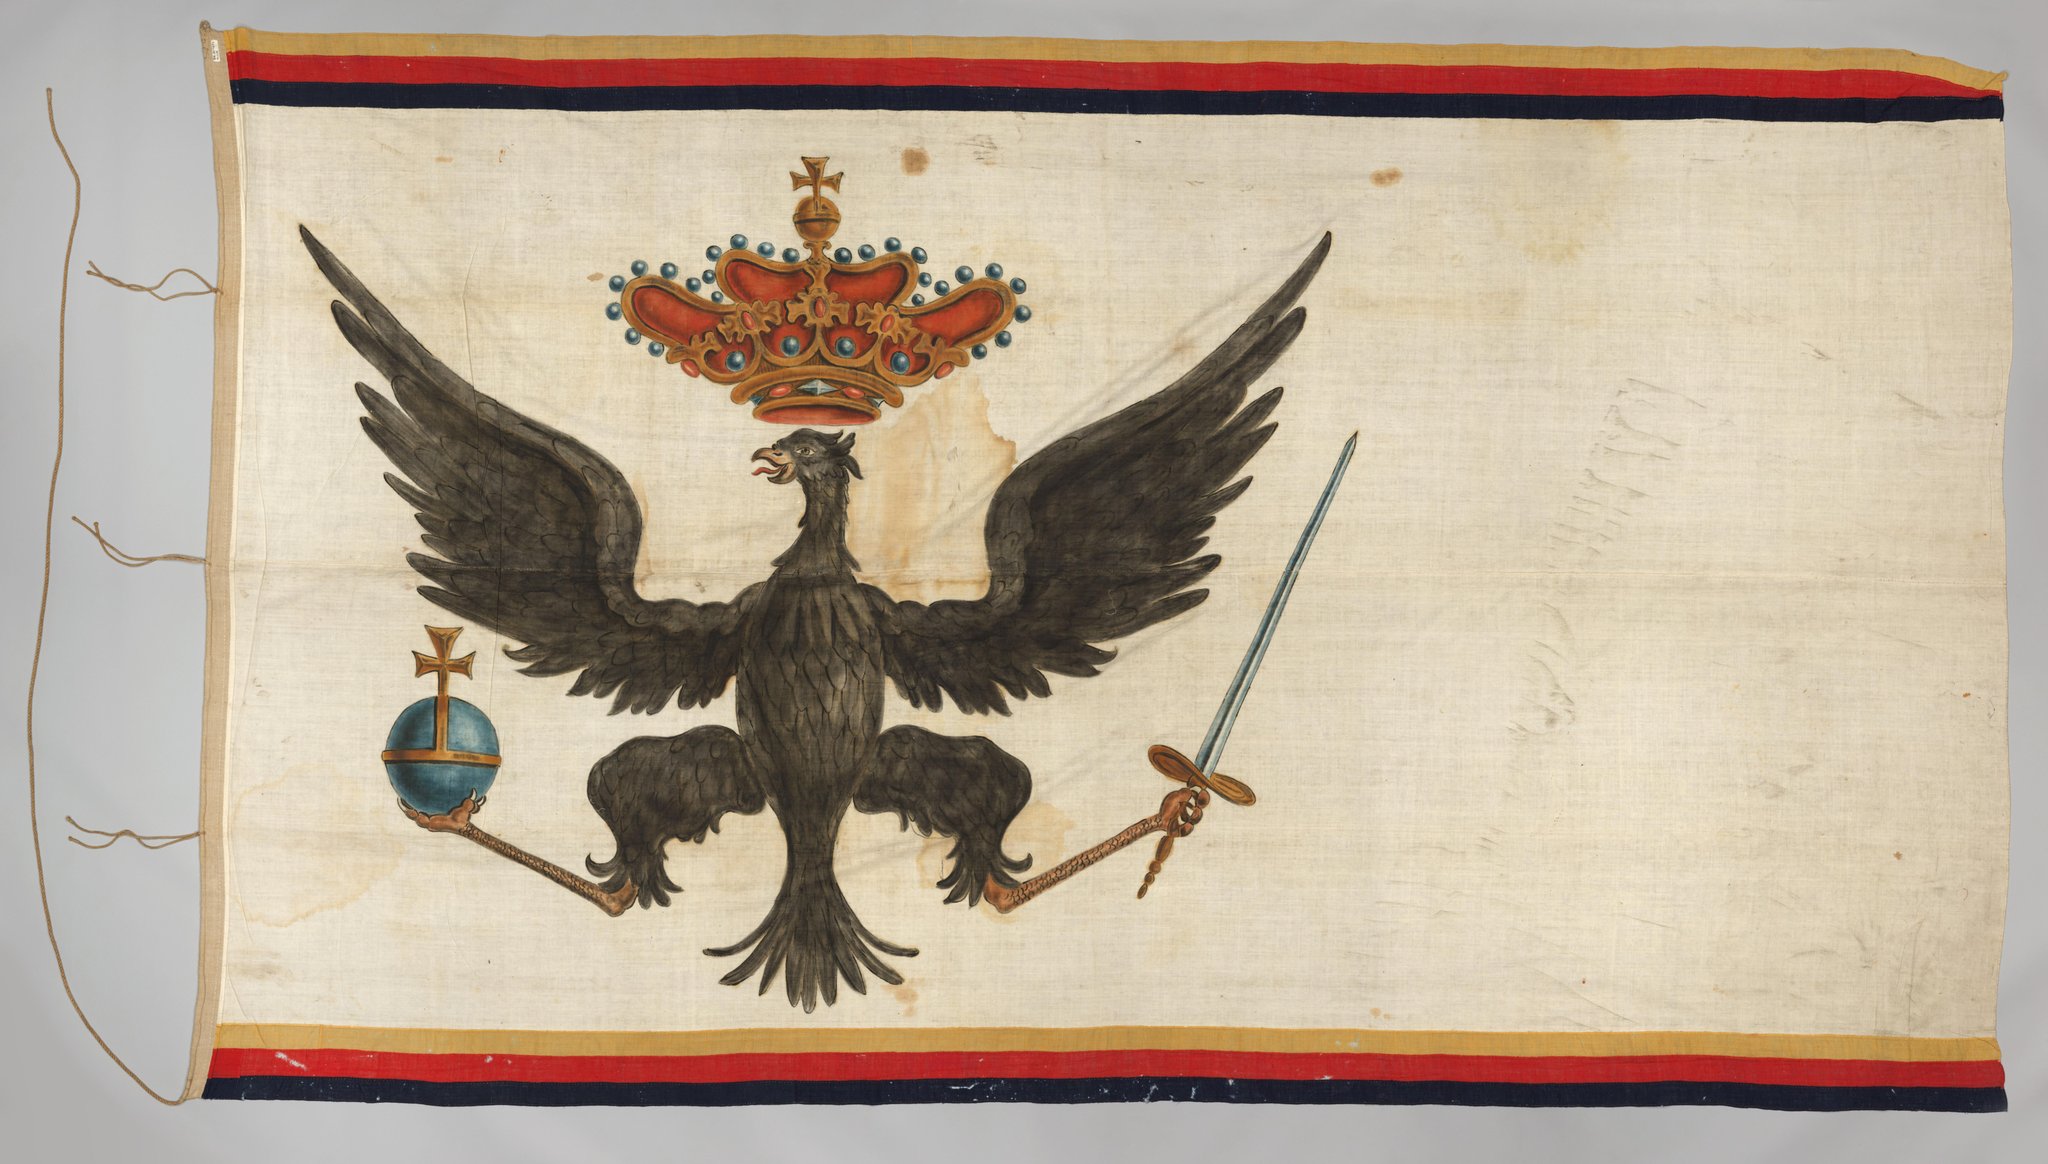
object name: flag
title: Pruisische vlag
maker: Anonymous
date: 1865-1900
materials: cotton, paint, wool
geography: germany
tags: pruisen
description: Witte vlag, met aan broekzijde een zwarte adelaar met in de linkerklauw een opgestoken zwaard, in de rechterklauw een rijksappel. Boven de naar broekzijde ziende kop een kroon met vijf beugels, met parels, fleurons en rode muts. Achterkant identiek. Aan de boven- en onderzijden smalle banen geel-rood- zwart. Aan de broek vijf bevestigingstouwtjes. Op de broek: T.R.51-1953 N.O.M.